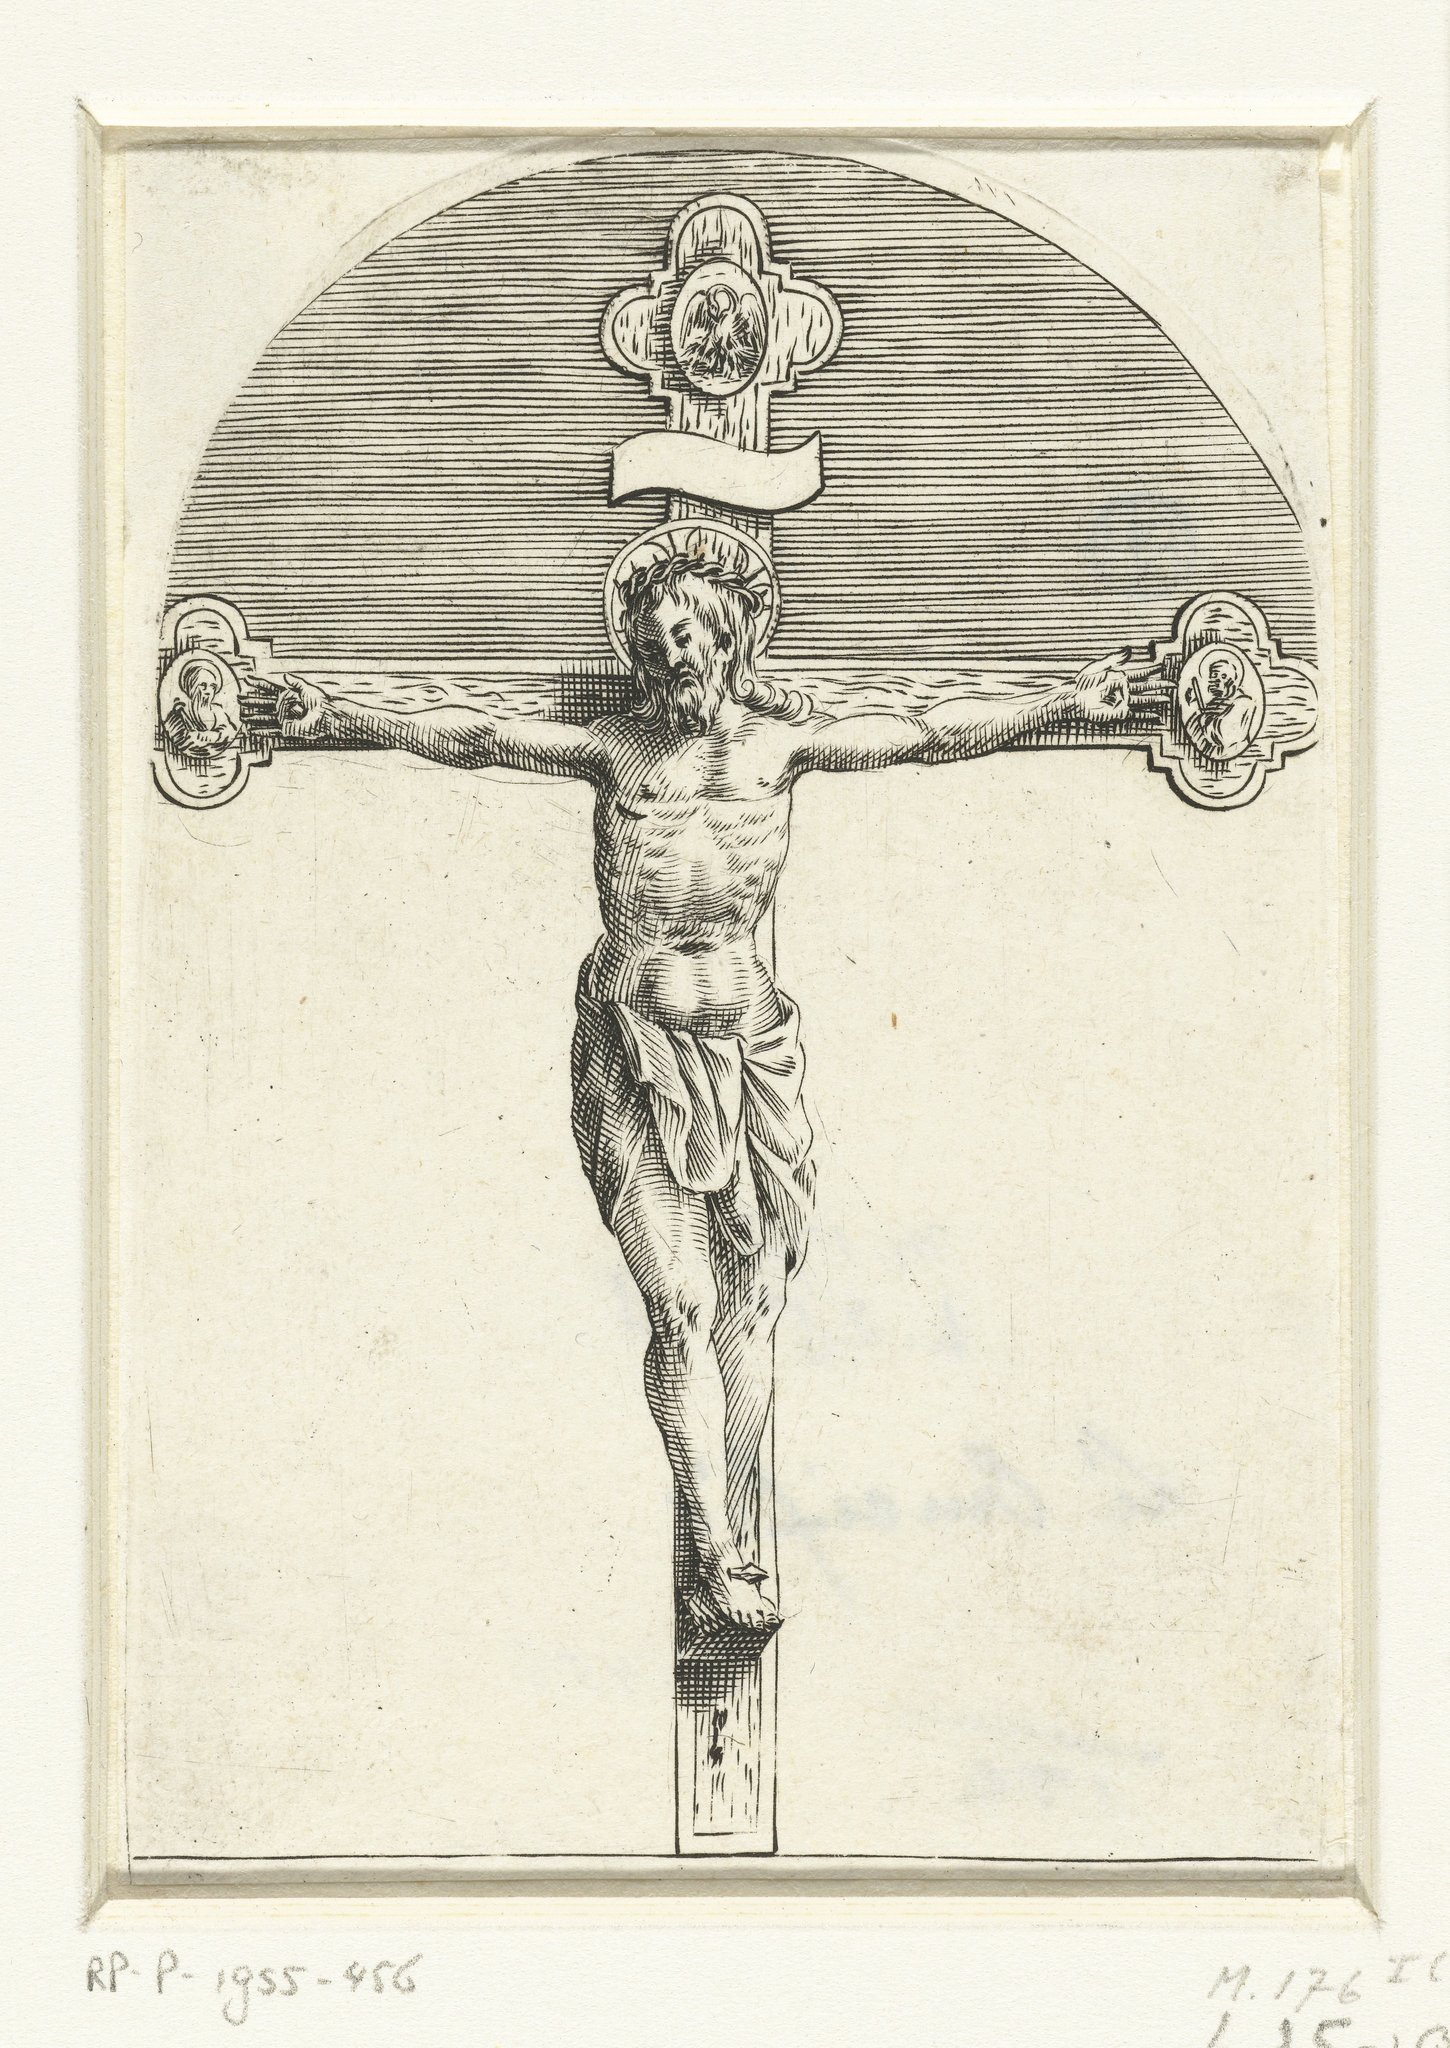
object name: print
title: Kruisiging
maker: jacques callot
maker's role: draughtsman, print maker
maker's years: 1592-1635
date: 1608-1611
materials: paper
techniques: engraving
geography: rome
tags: symbols of christ ~ animals, other types of crucified christ in non-narrative context, the apostle peter, first bishop of rome; possible attributes: book, cock, (upturned) cross, (triple) crozier, fish, key, scroll, ship, tiara, the apostle paul of tarsus; possible attributes: book, scroll, sword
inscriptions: collector's mark: Lugt 2215b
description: Christus aan het kruis; bij zijn rechterhand een beeltenis van de Heilige Paulus, bij zijn linkerhand een beeltenis van de Heilige Petrus, boven zijn hoofd een voorstelling van de pelikaan die zijn jongen voedt met zijn eigen bloed. Deze prent is onderdeel van (de eerste staat van) een serie van 30 prenten, bestaande uit een titelprent en 29 voorstellingen van schilderijen en sculpturen in kerken te Rome.